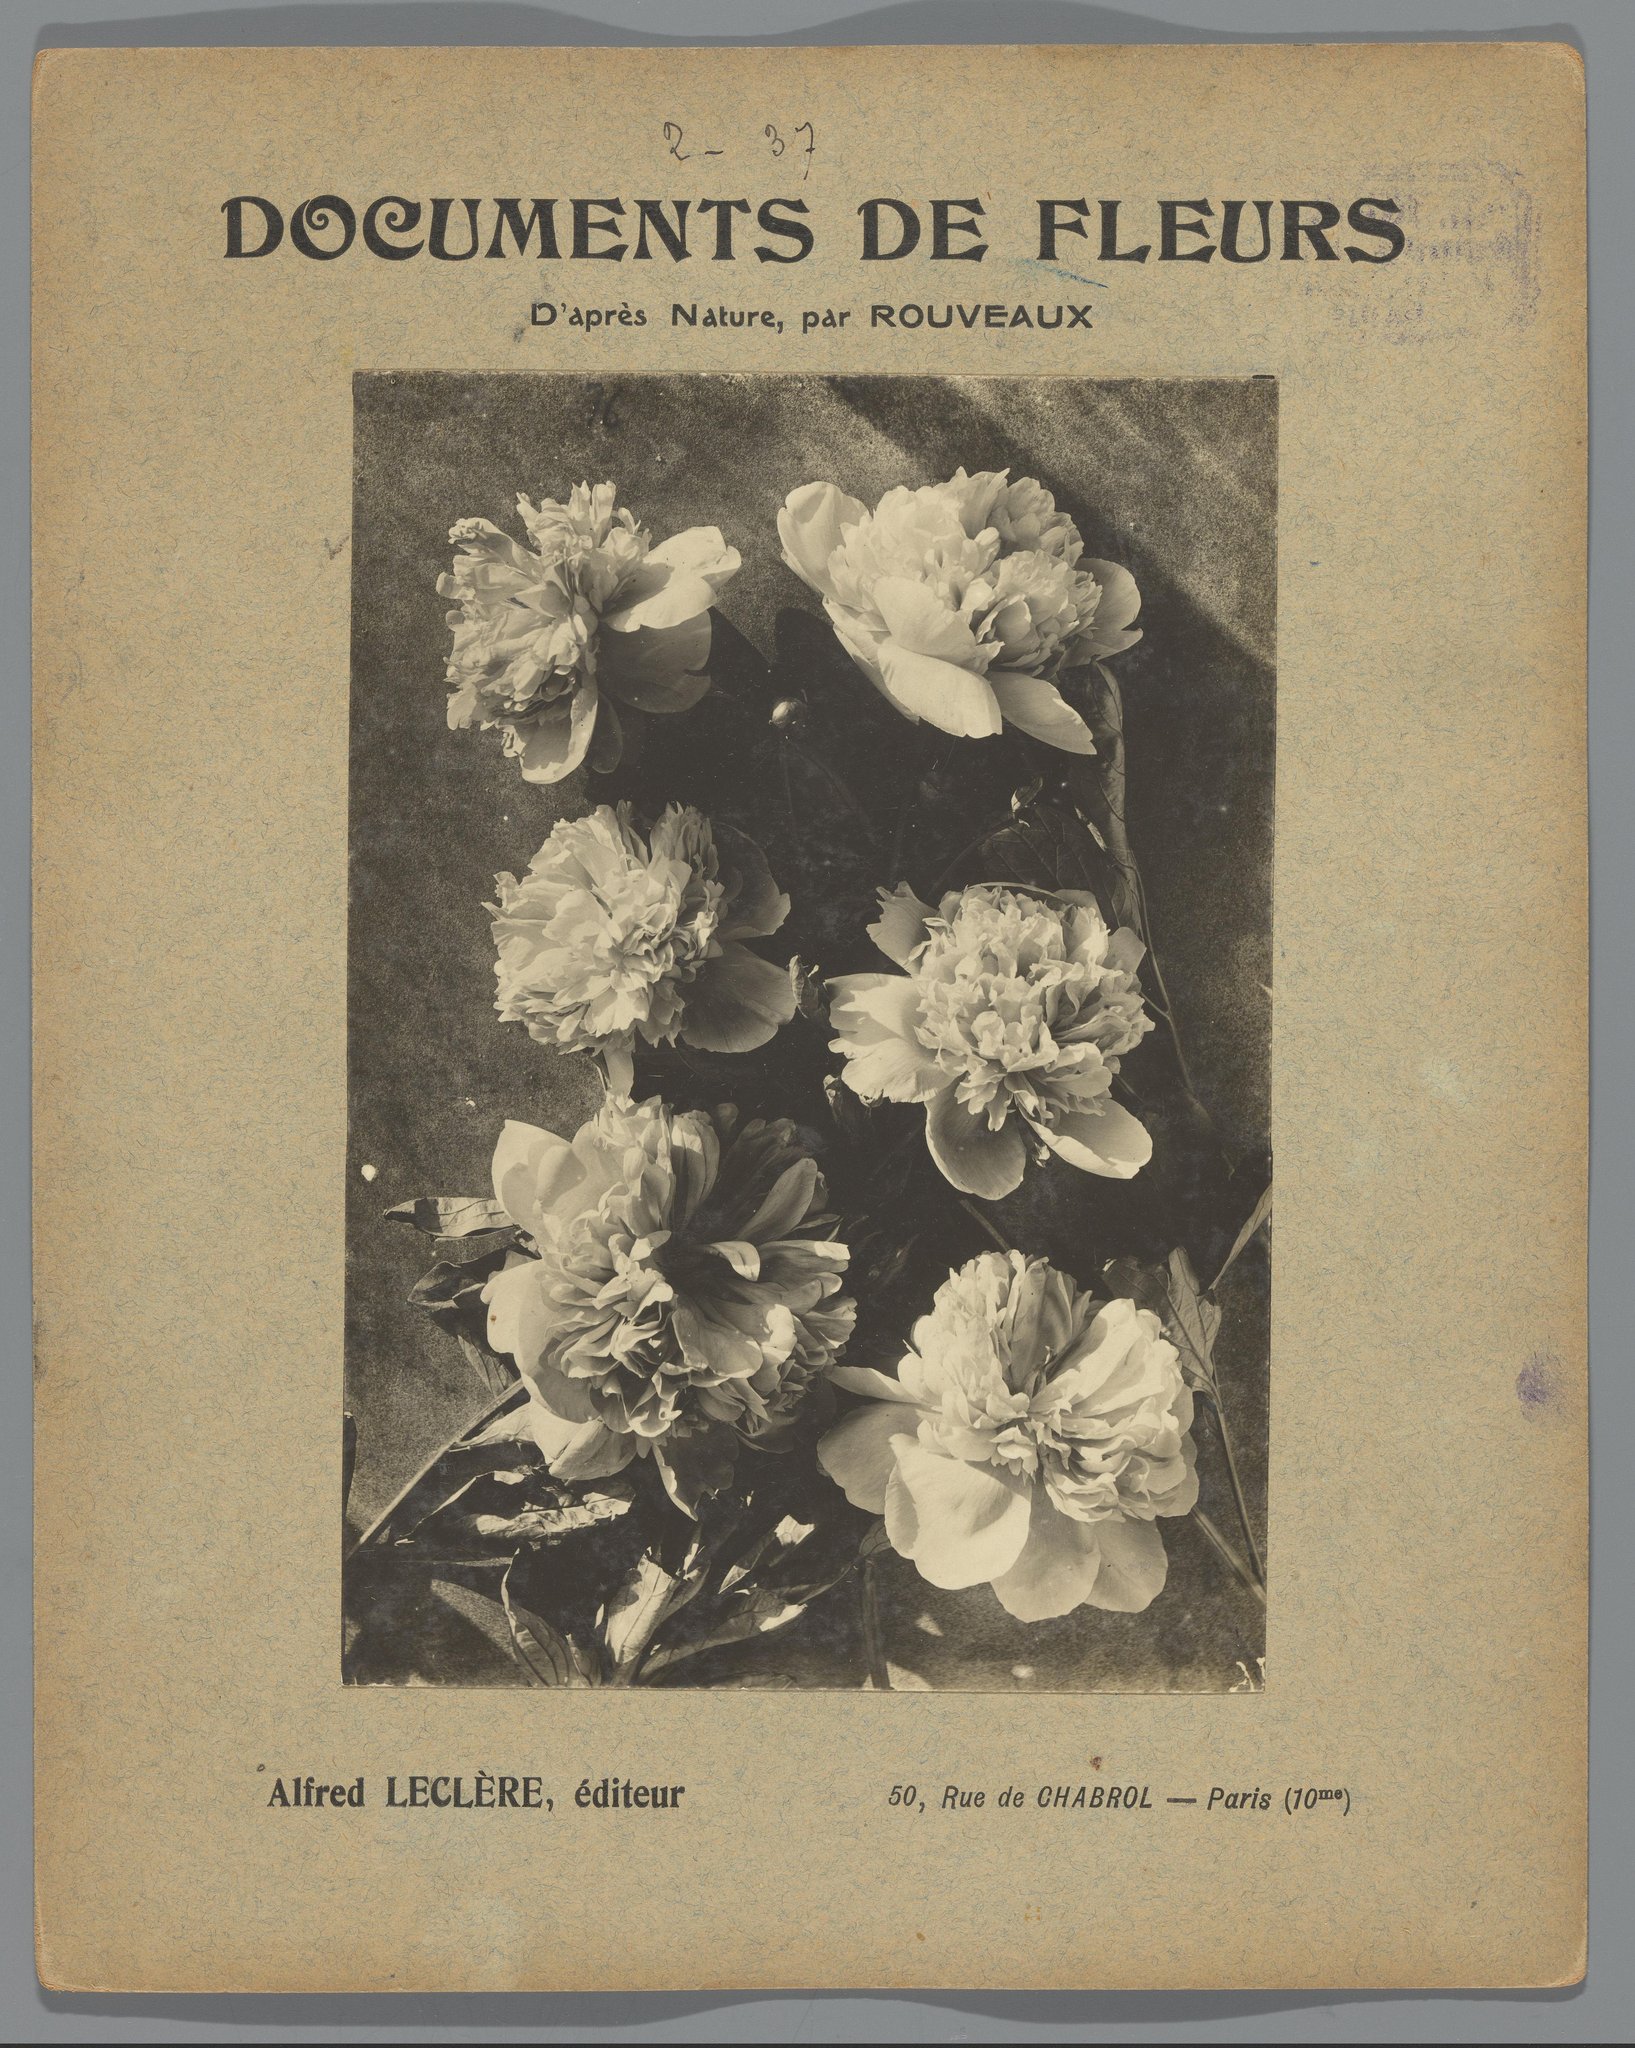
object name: photograph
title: Bloemstudie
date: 1895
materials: photographic support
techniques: gelatin silver print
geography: france